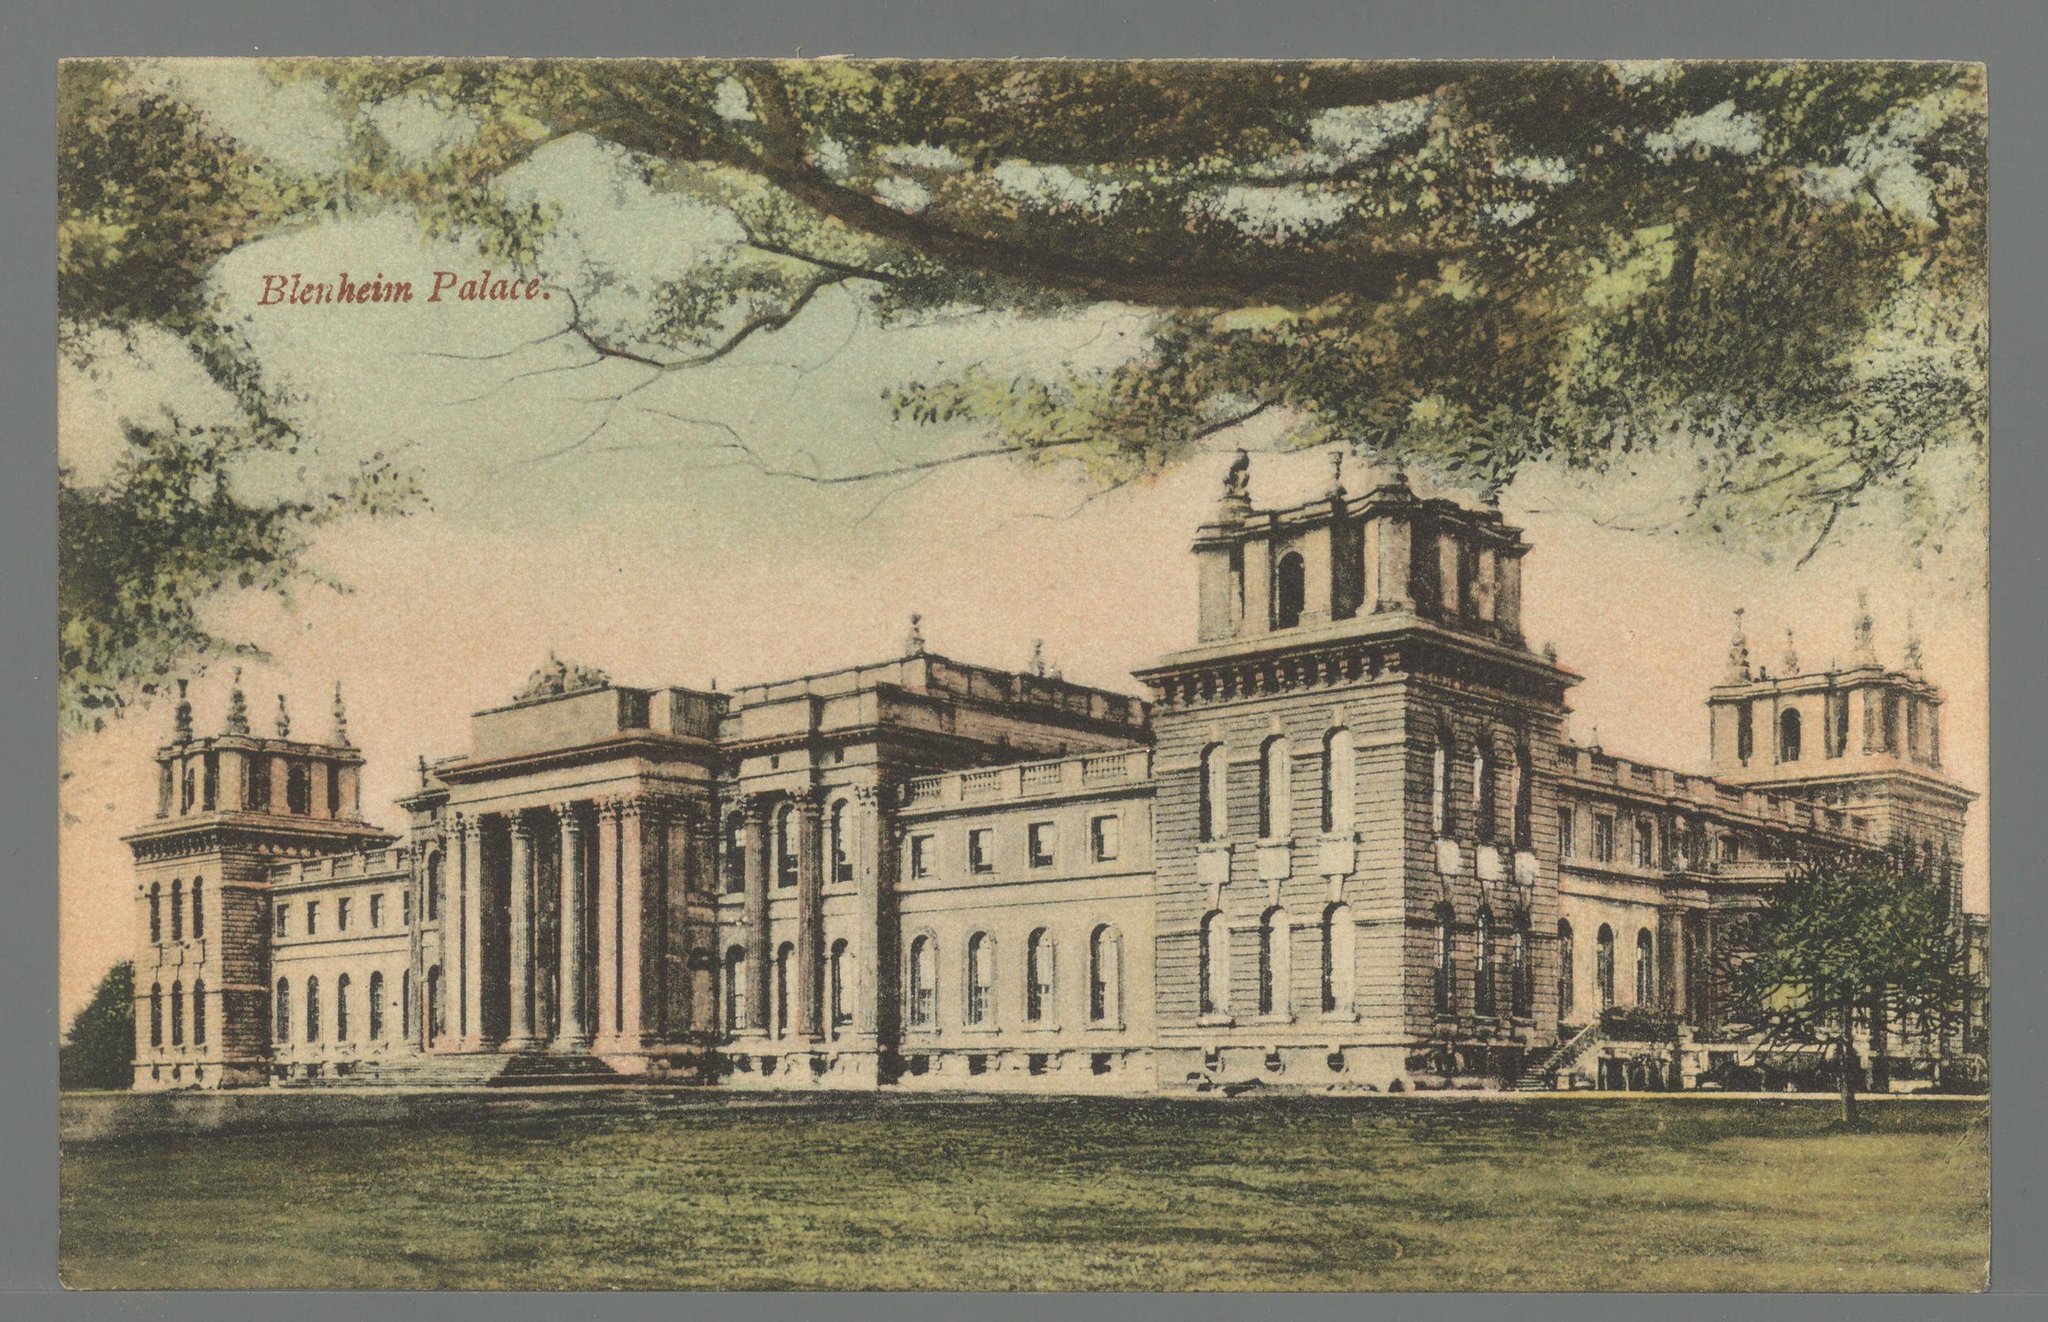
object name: photomechanical print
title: Blenheim Palace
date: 1902-1909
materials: cardboard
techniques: photograph, lithograph, writing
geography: oxfordshire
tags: palace